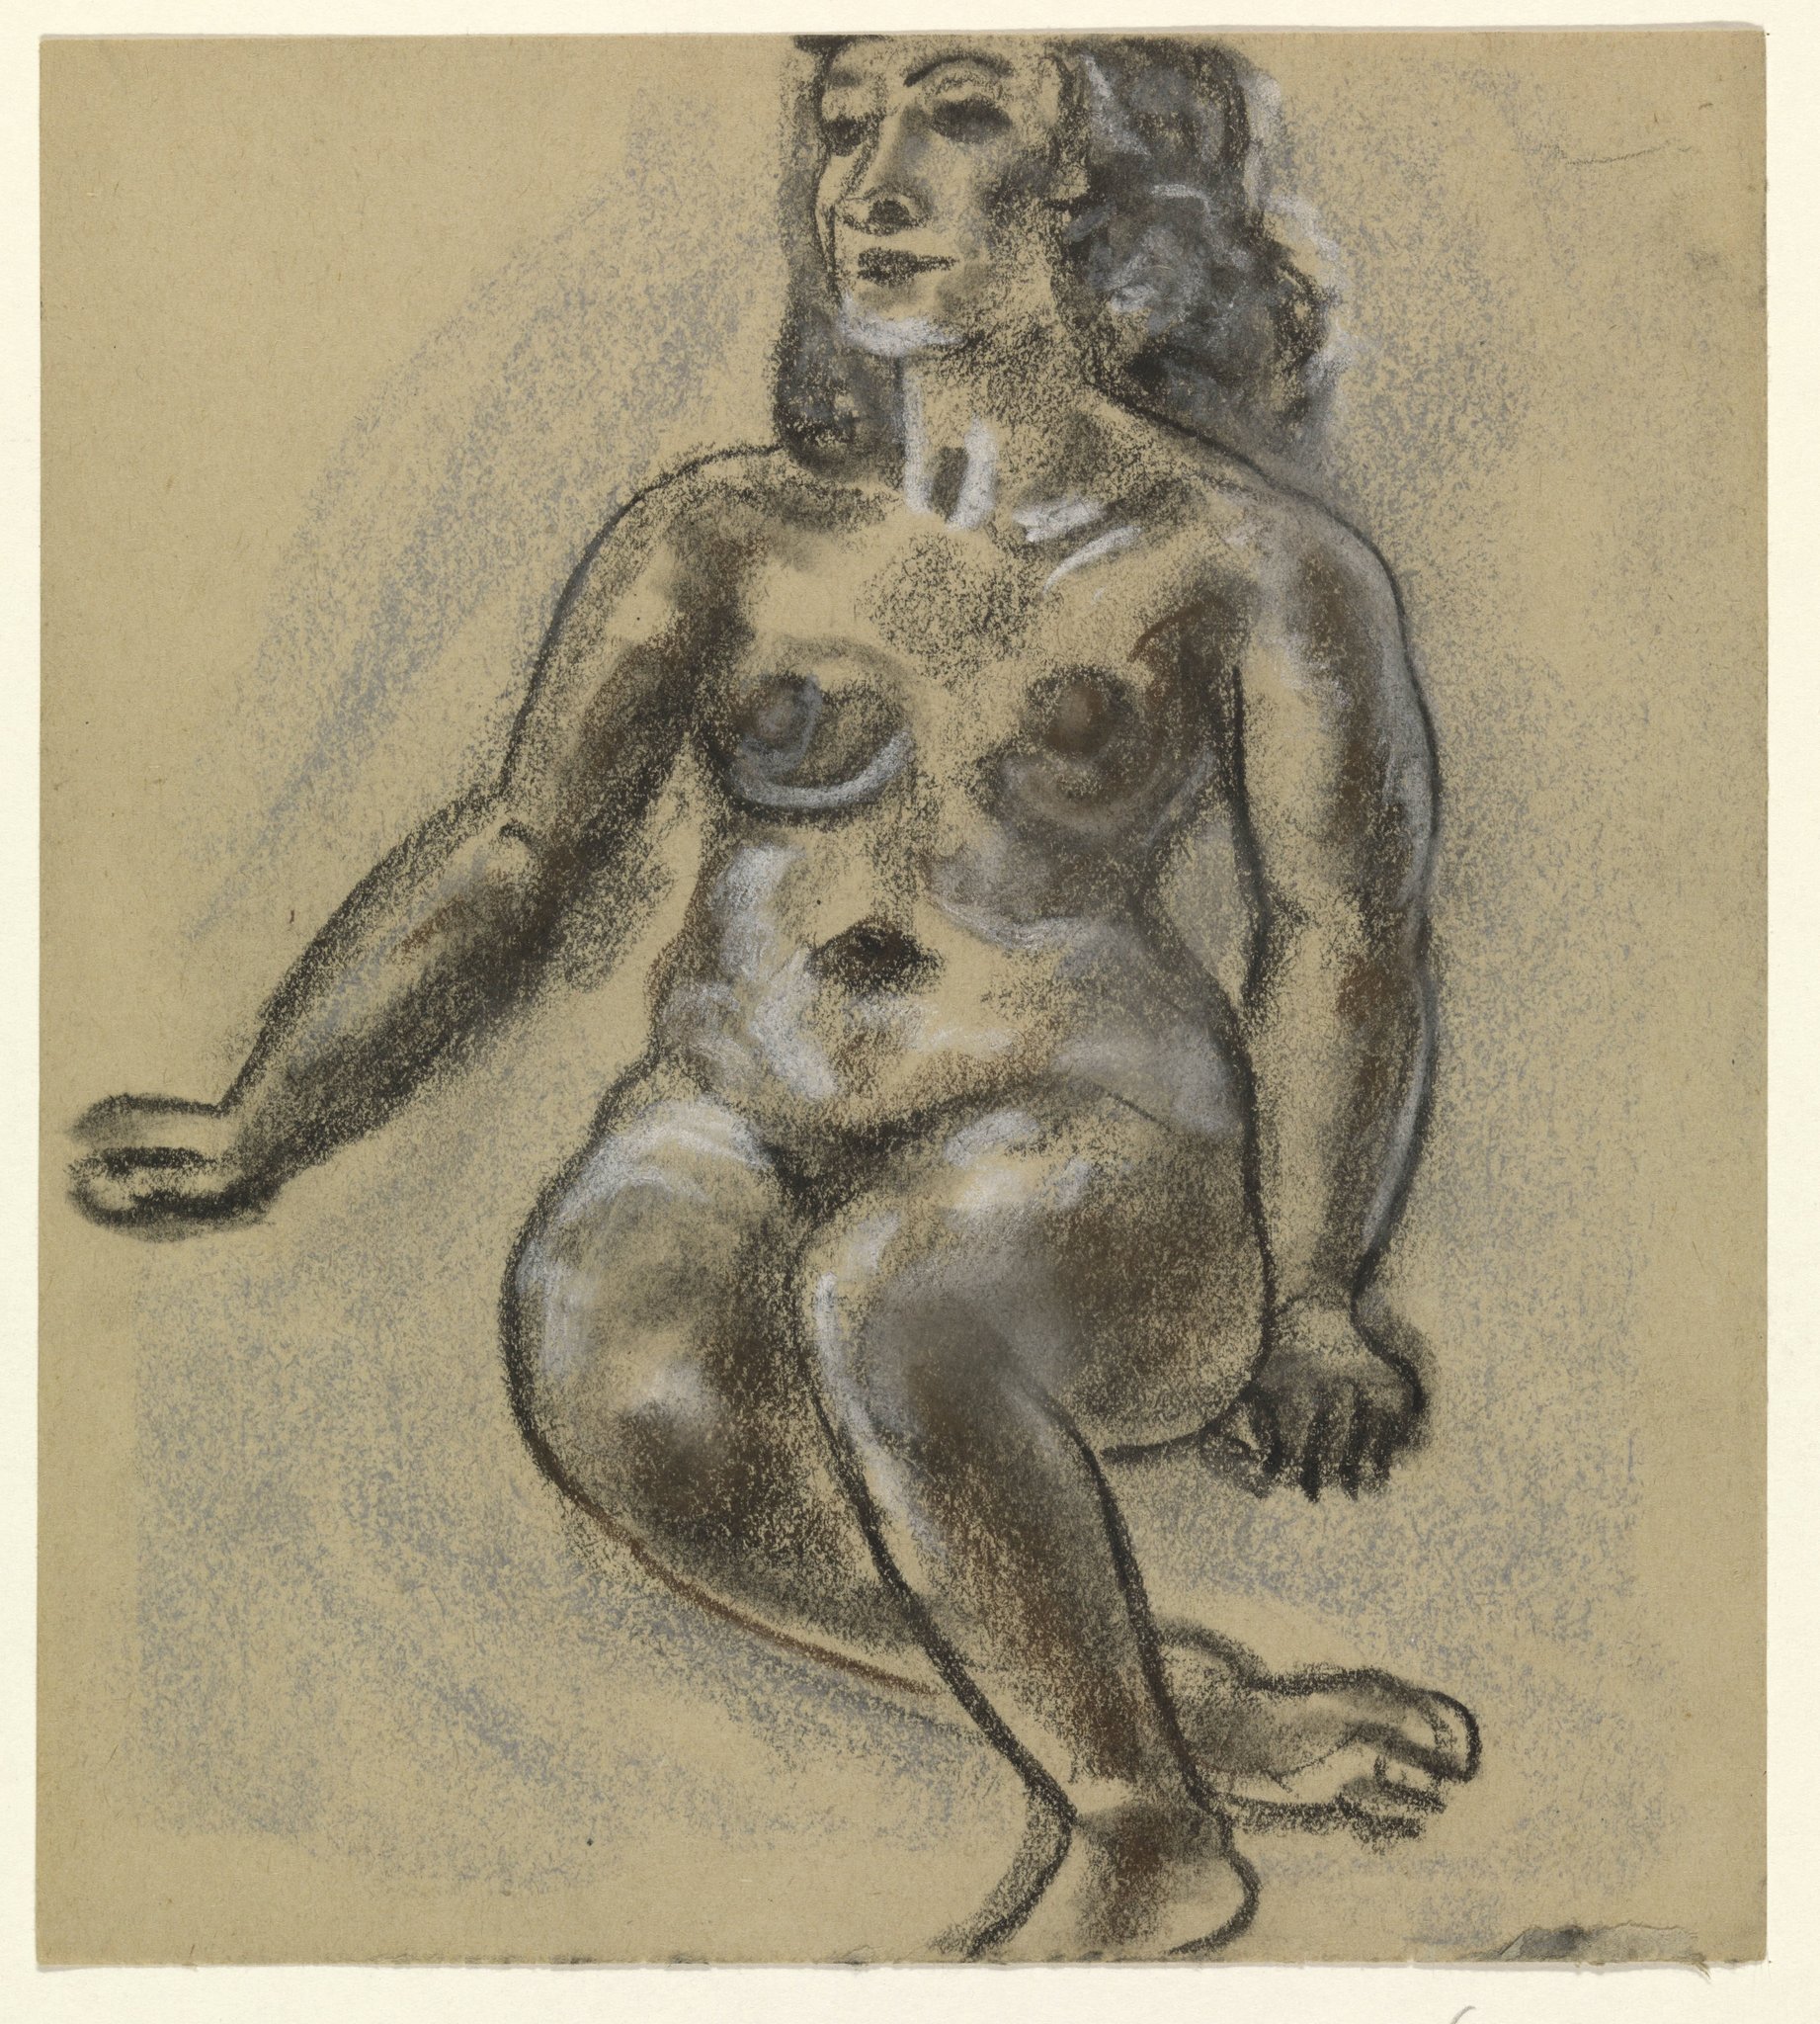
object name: drawing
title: Seated Female Nude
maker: leo gestel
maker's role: draughtsman, print maker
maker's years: 1881-1941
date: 1891-1941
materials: chalk, paper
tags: sitting figure - aa - female human figure (+ nude human being)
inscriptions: collector's mark: Lugt 2228